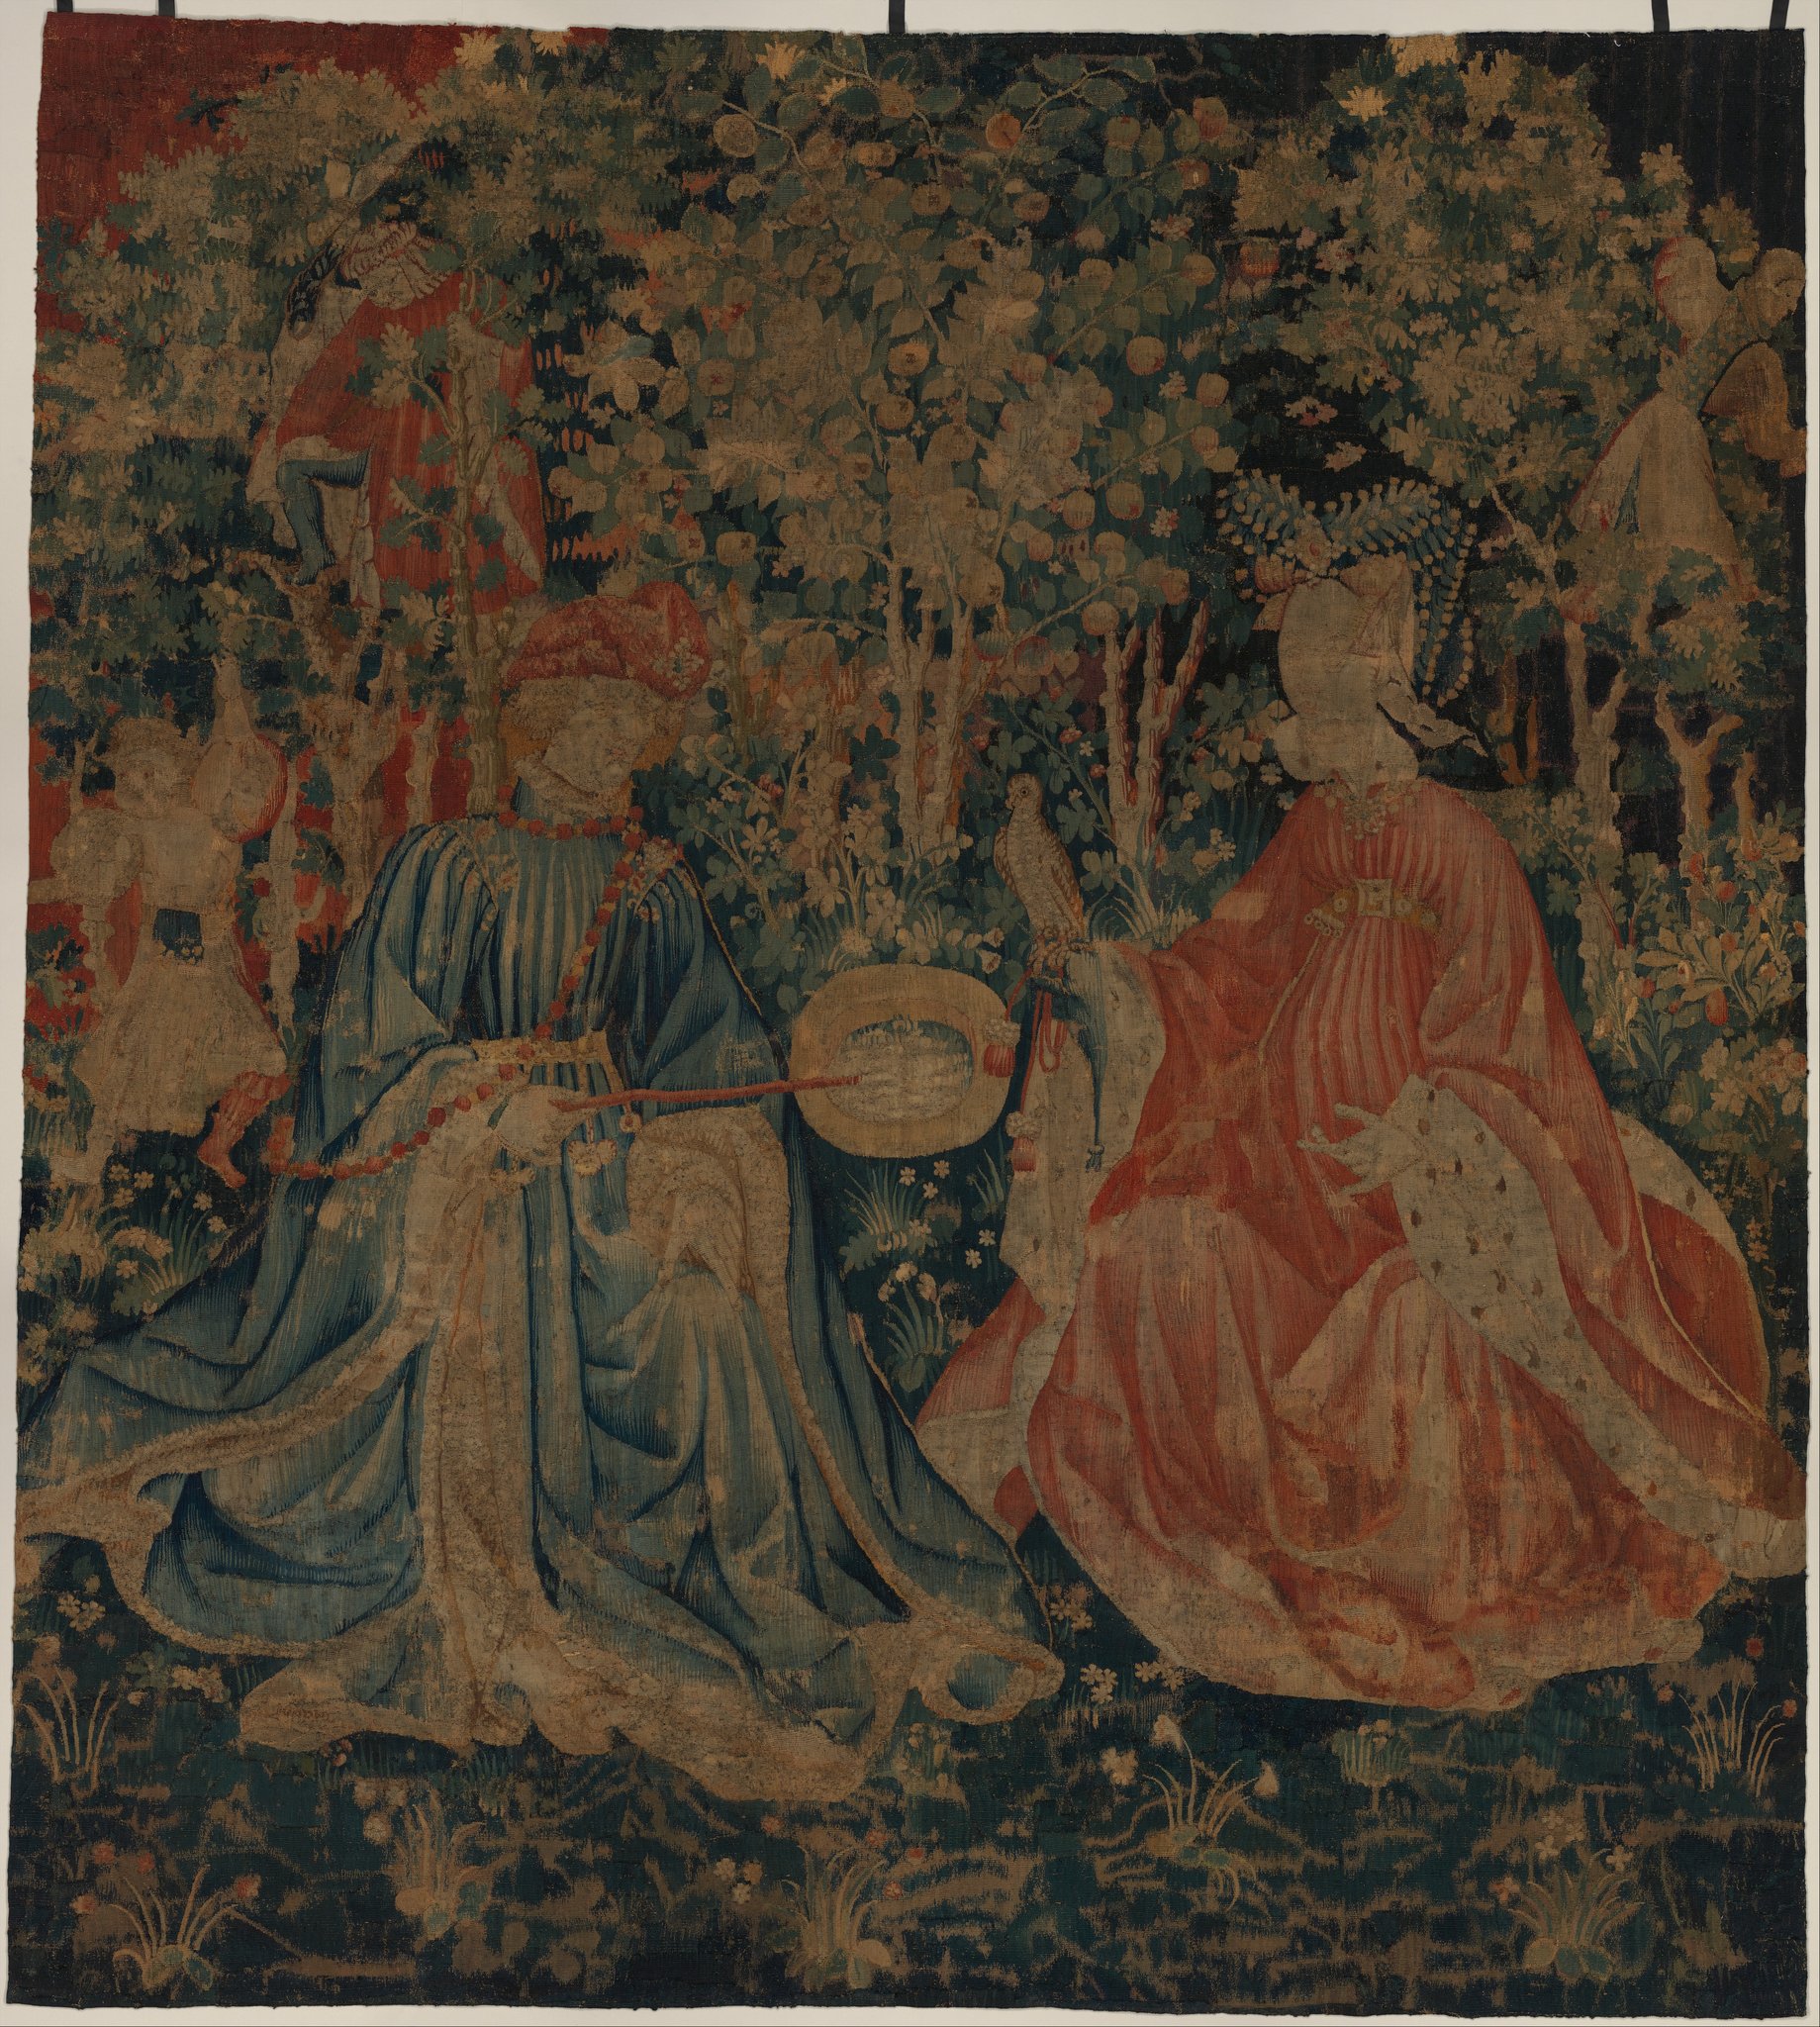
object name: tapestry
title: The Falcon's Bath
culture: south netherlandish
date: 1400-1415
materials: wool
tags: falcons,men,women,trees